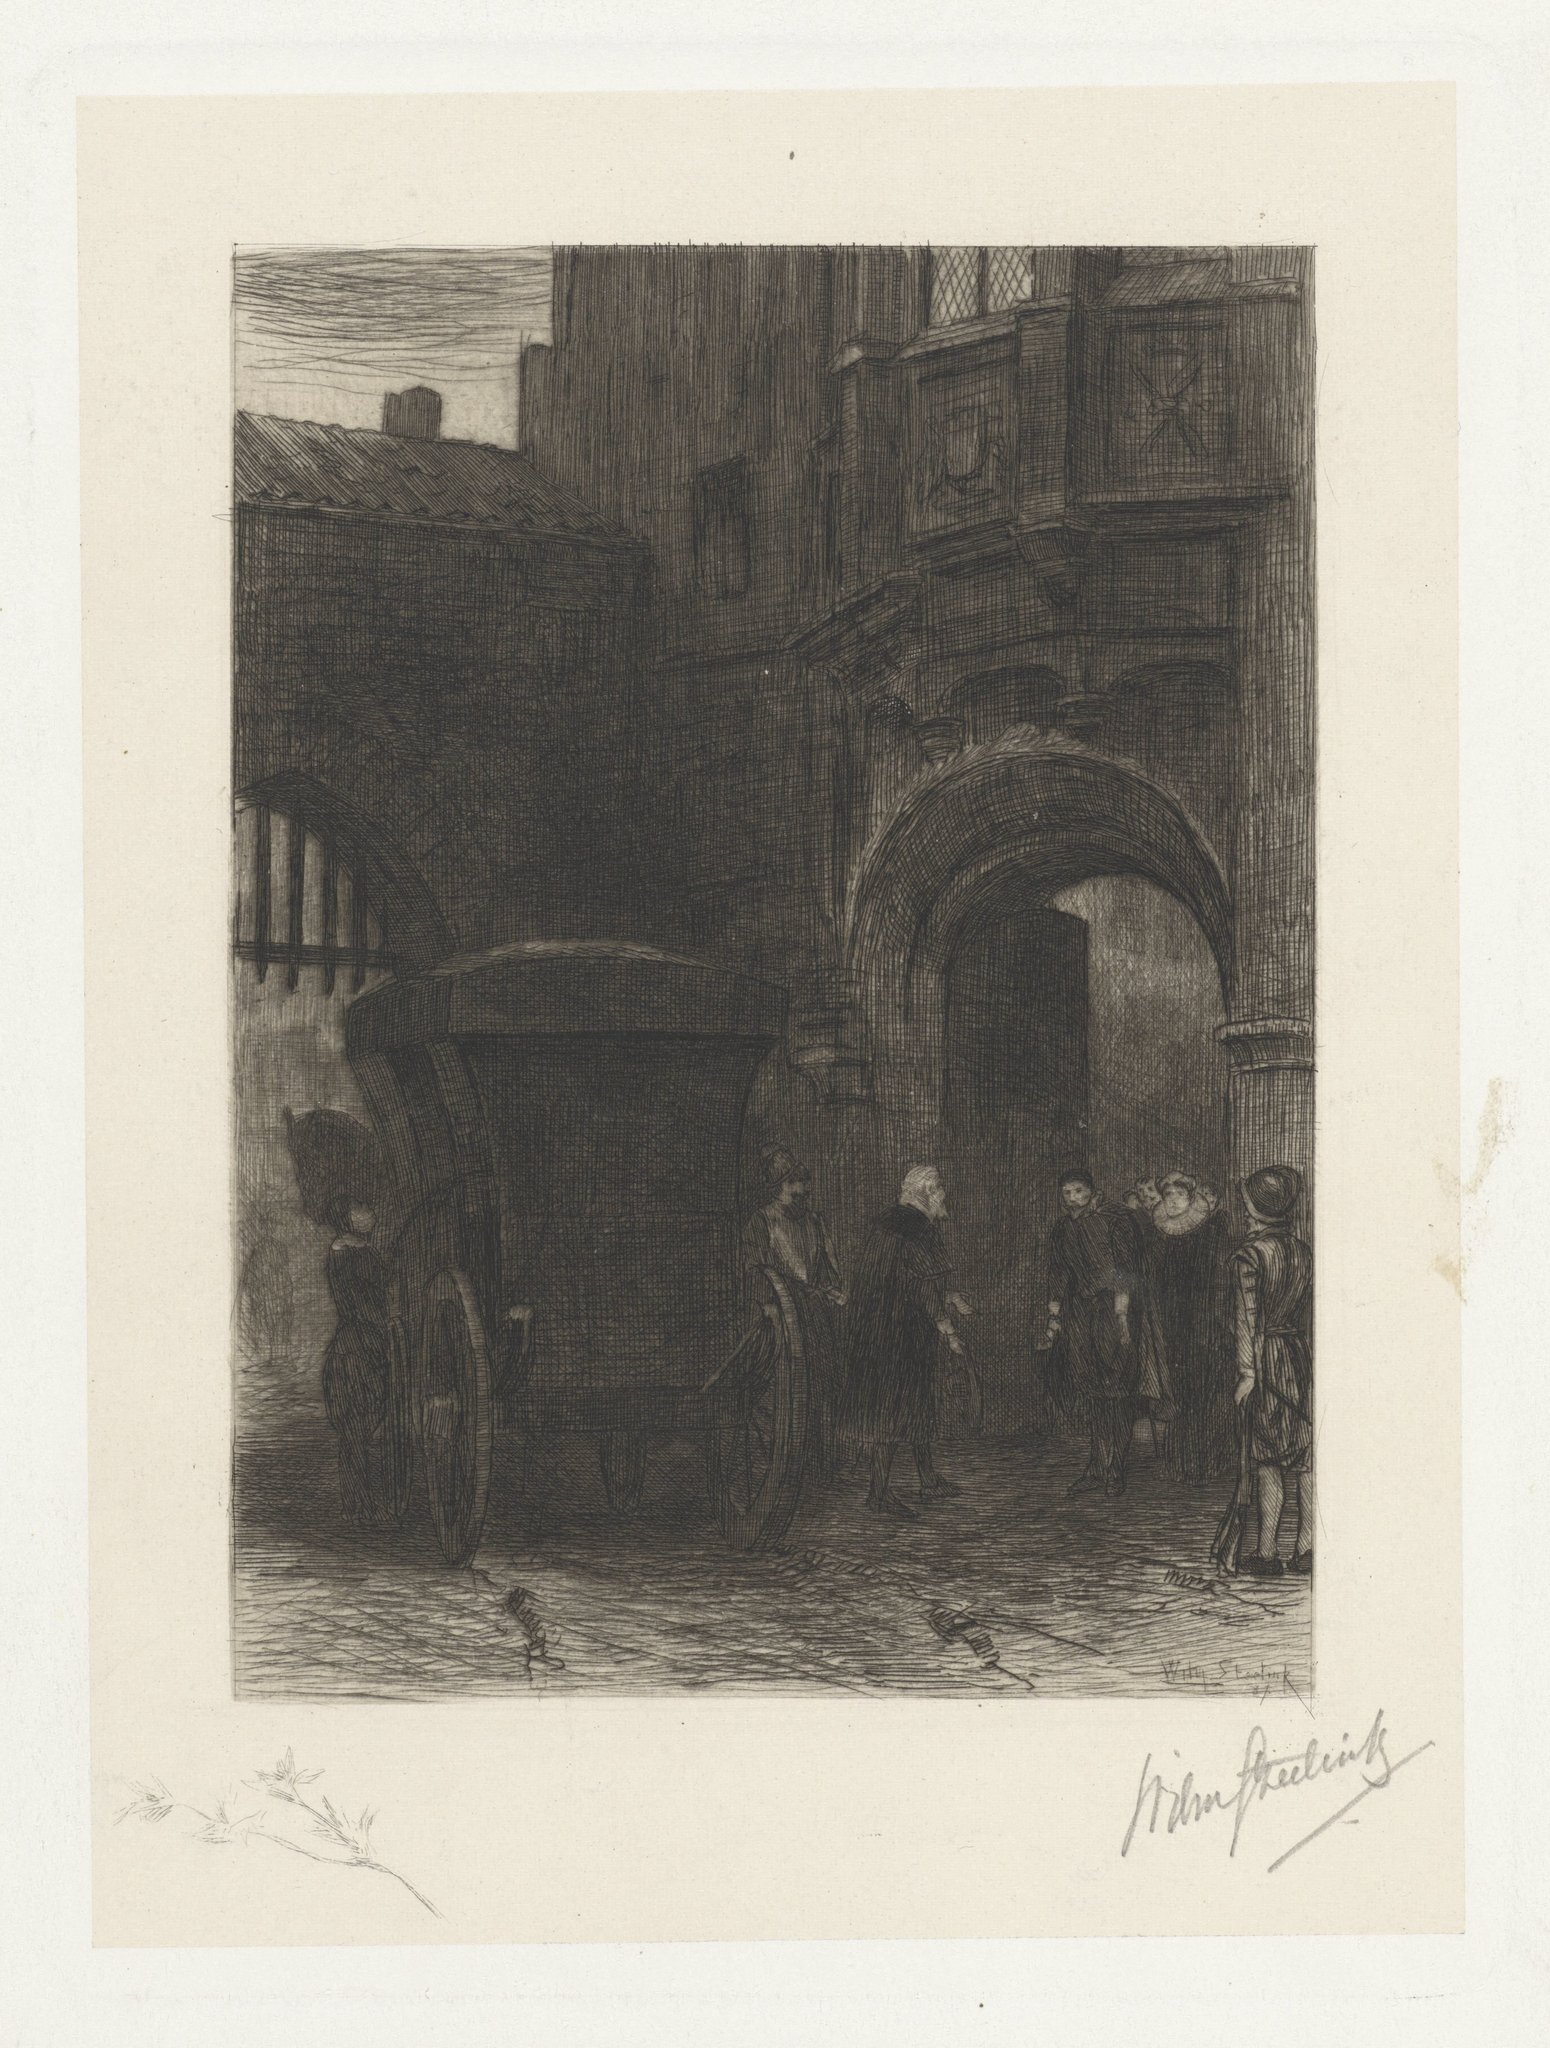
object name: print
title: Onverwacht bezoek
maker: willem steelink (ii)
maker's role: draughtsman, print maker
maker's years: 1856-1928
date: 1887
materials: paper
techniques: etching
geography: netherlands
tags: four-wheeled, animal-drawn vehicle, e.g.: cab, carriage, coach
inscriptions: collector's mark: Lugt 2228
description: Een onverwachtte gast staat bij het rijtuig waarmee hij is aangekomen. De gastheer en zijn vrouw staan in de poort en verwelkomen hem. Linksonder in de marge het takje van een distel.